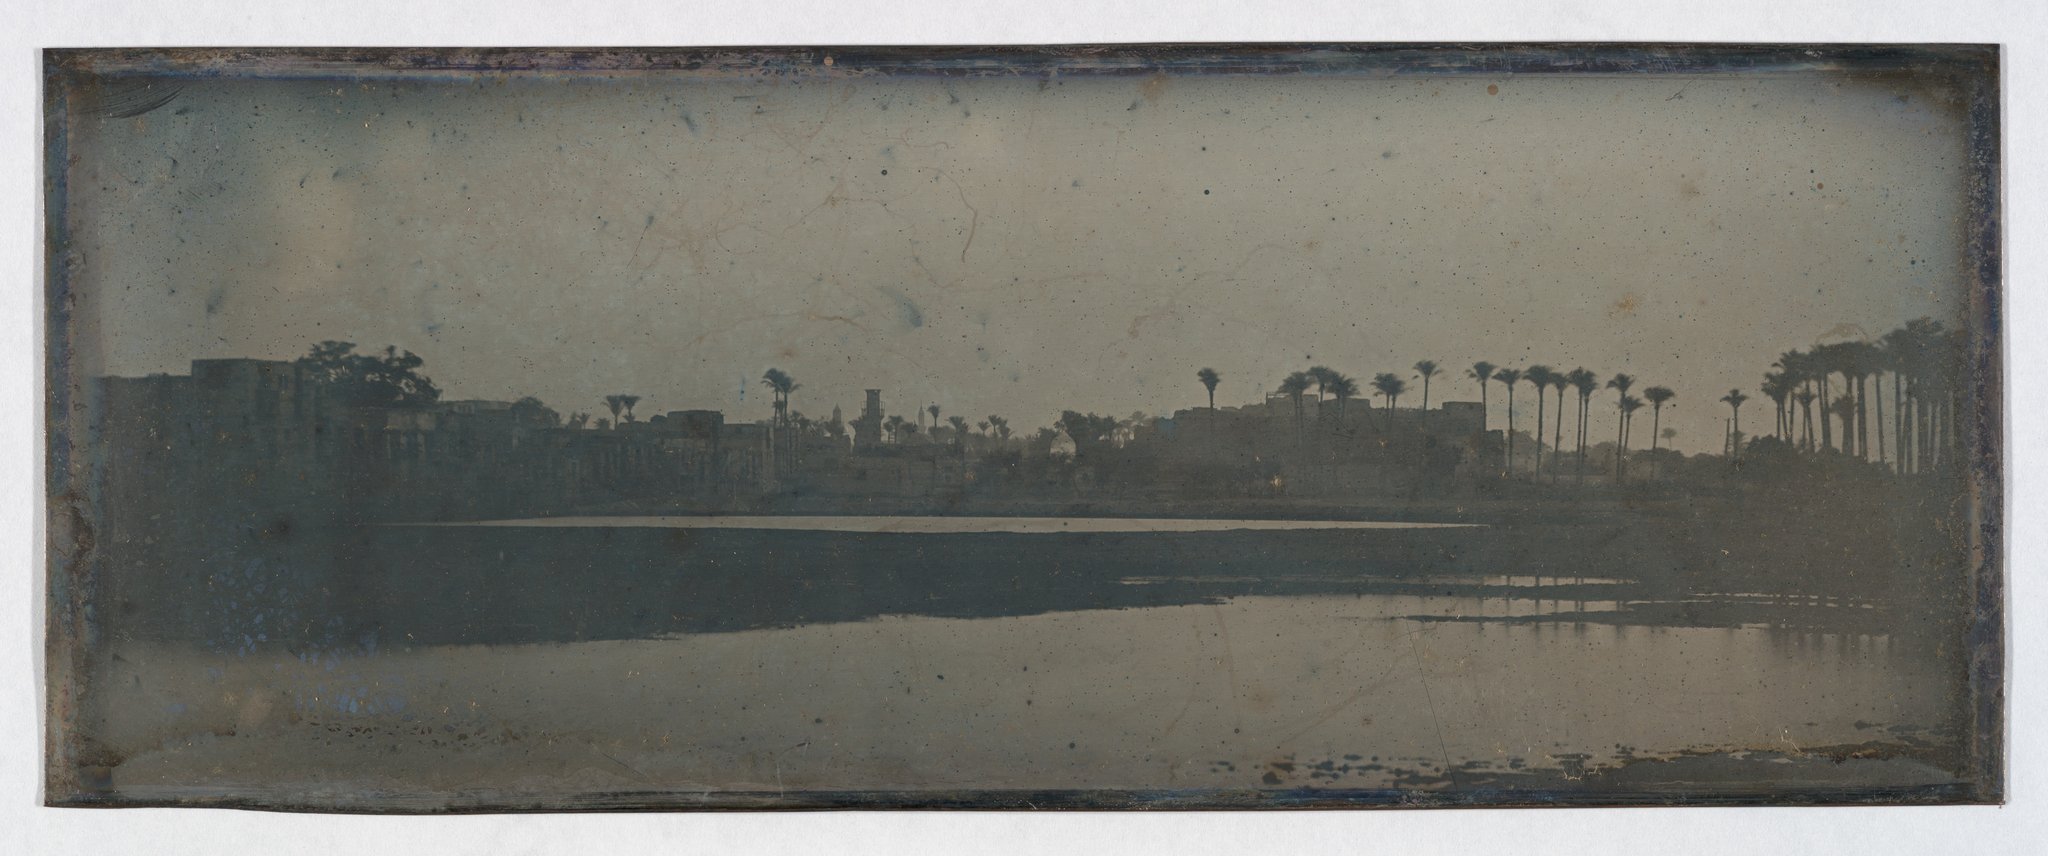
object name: photograph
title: [Egypt]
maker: joseph-philibert girault de prangey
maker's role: artist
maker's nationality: french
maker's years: 1804-1892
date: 1842-1844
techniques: daguerreotype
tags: landscapes